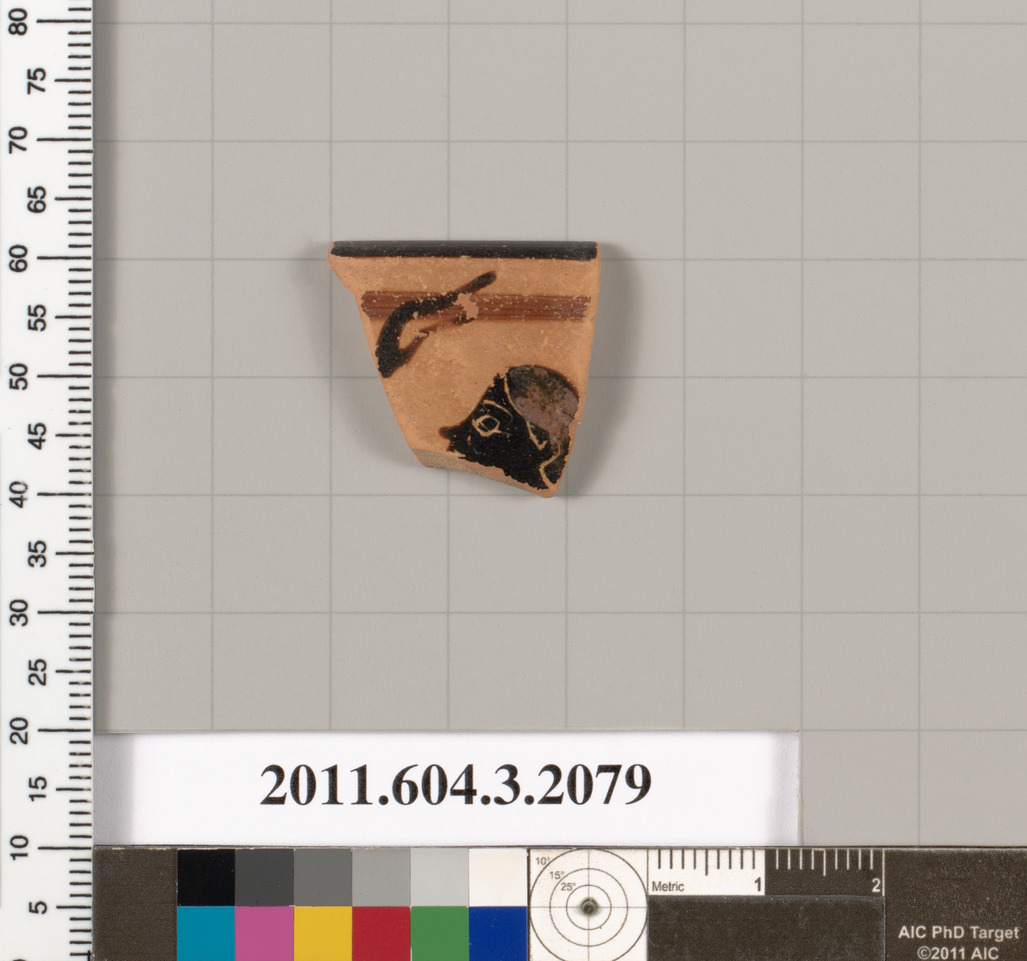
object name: kylix fragment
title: Terracotta rim fragment of a kylix (drinking cup)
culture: greek, attic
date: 534-468 BCE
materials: terracotta